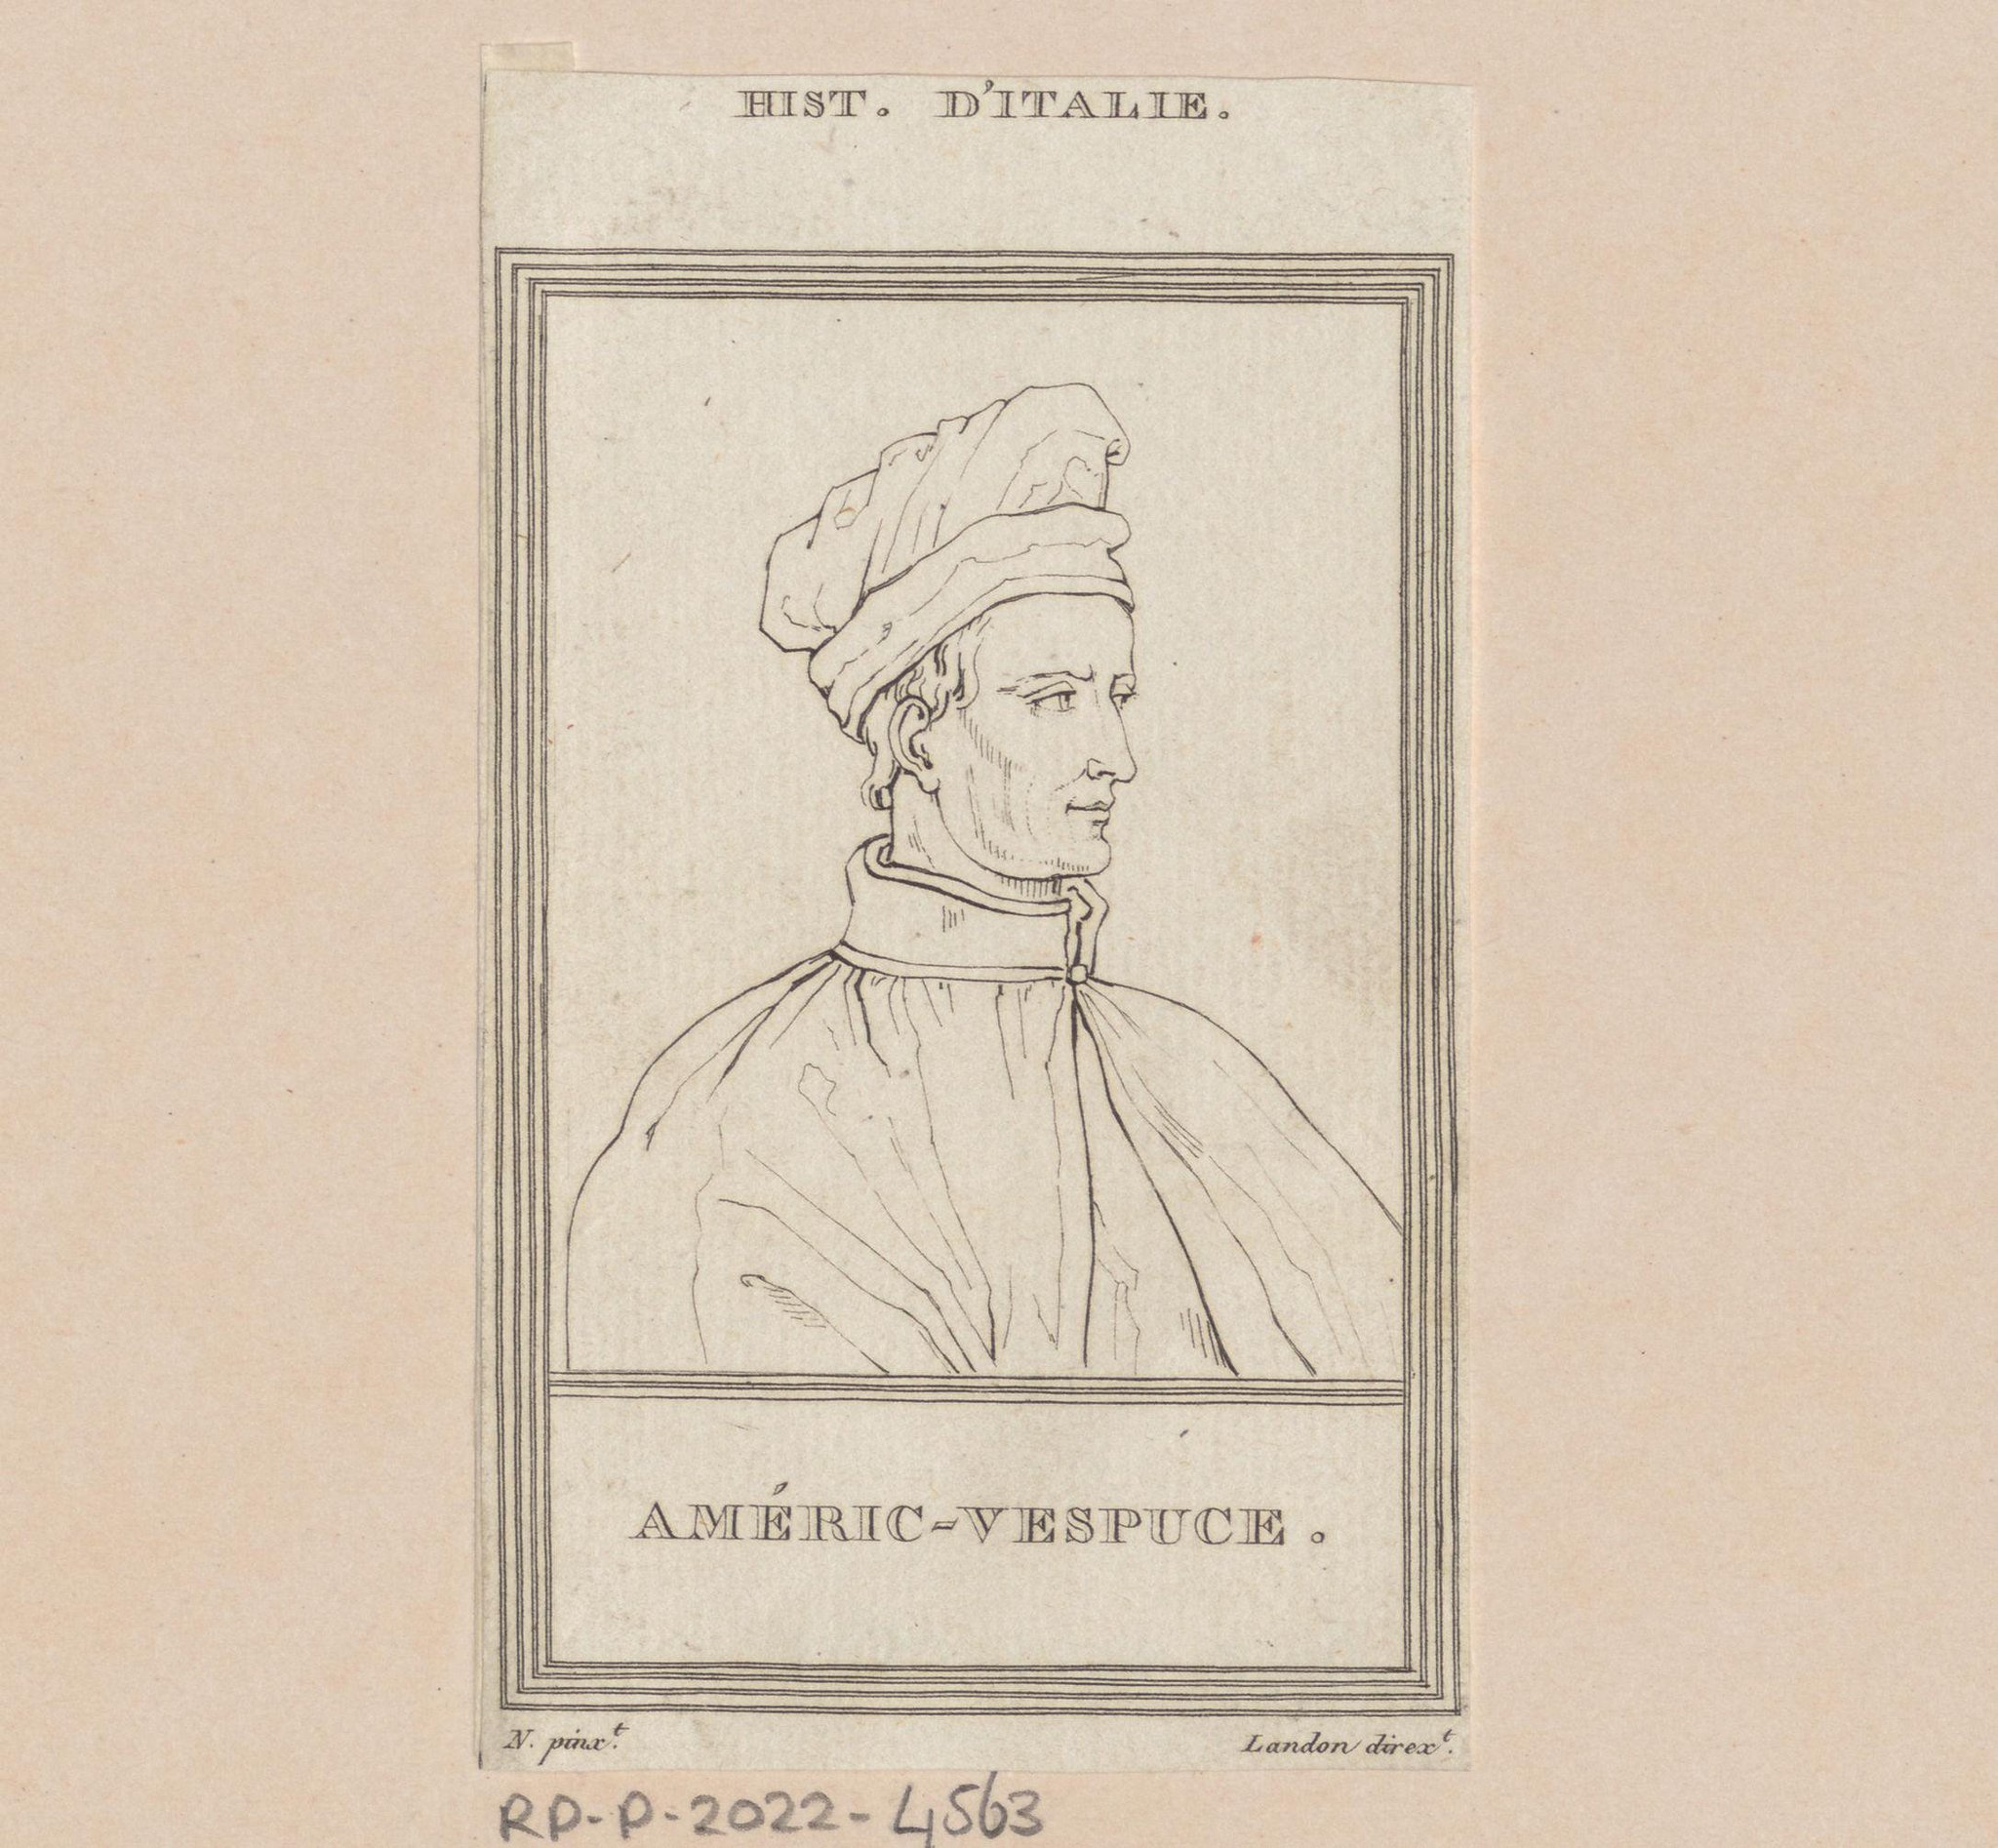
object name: print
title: Portret van Amerigo Vespucci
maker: charles paul landon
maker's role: painter, print maker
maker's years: 1760-1826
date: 1805-1811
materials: paper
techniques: woodcut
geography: france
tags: sevilla, historical persons, explorer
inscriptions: monogram: ‘N.’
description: Prent waarschijnlijk uit een deel van: Galerie historique des hommes les plus célèbres (...). Parijs: Charles Paul Landon, 1805-1811.